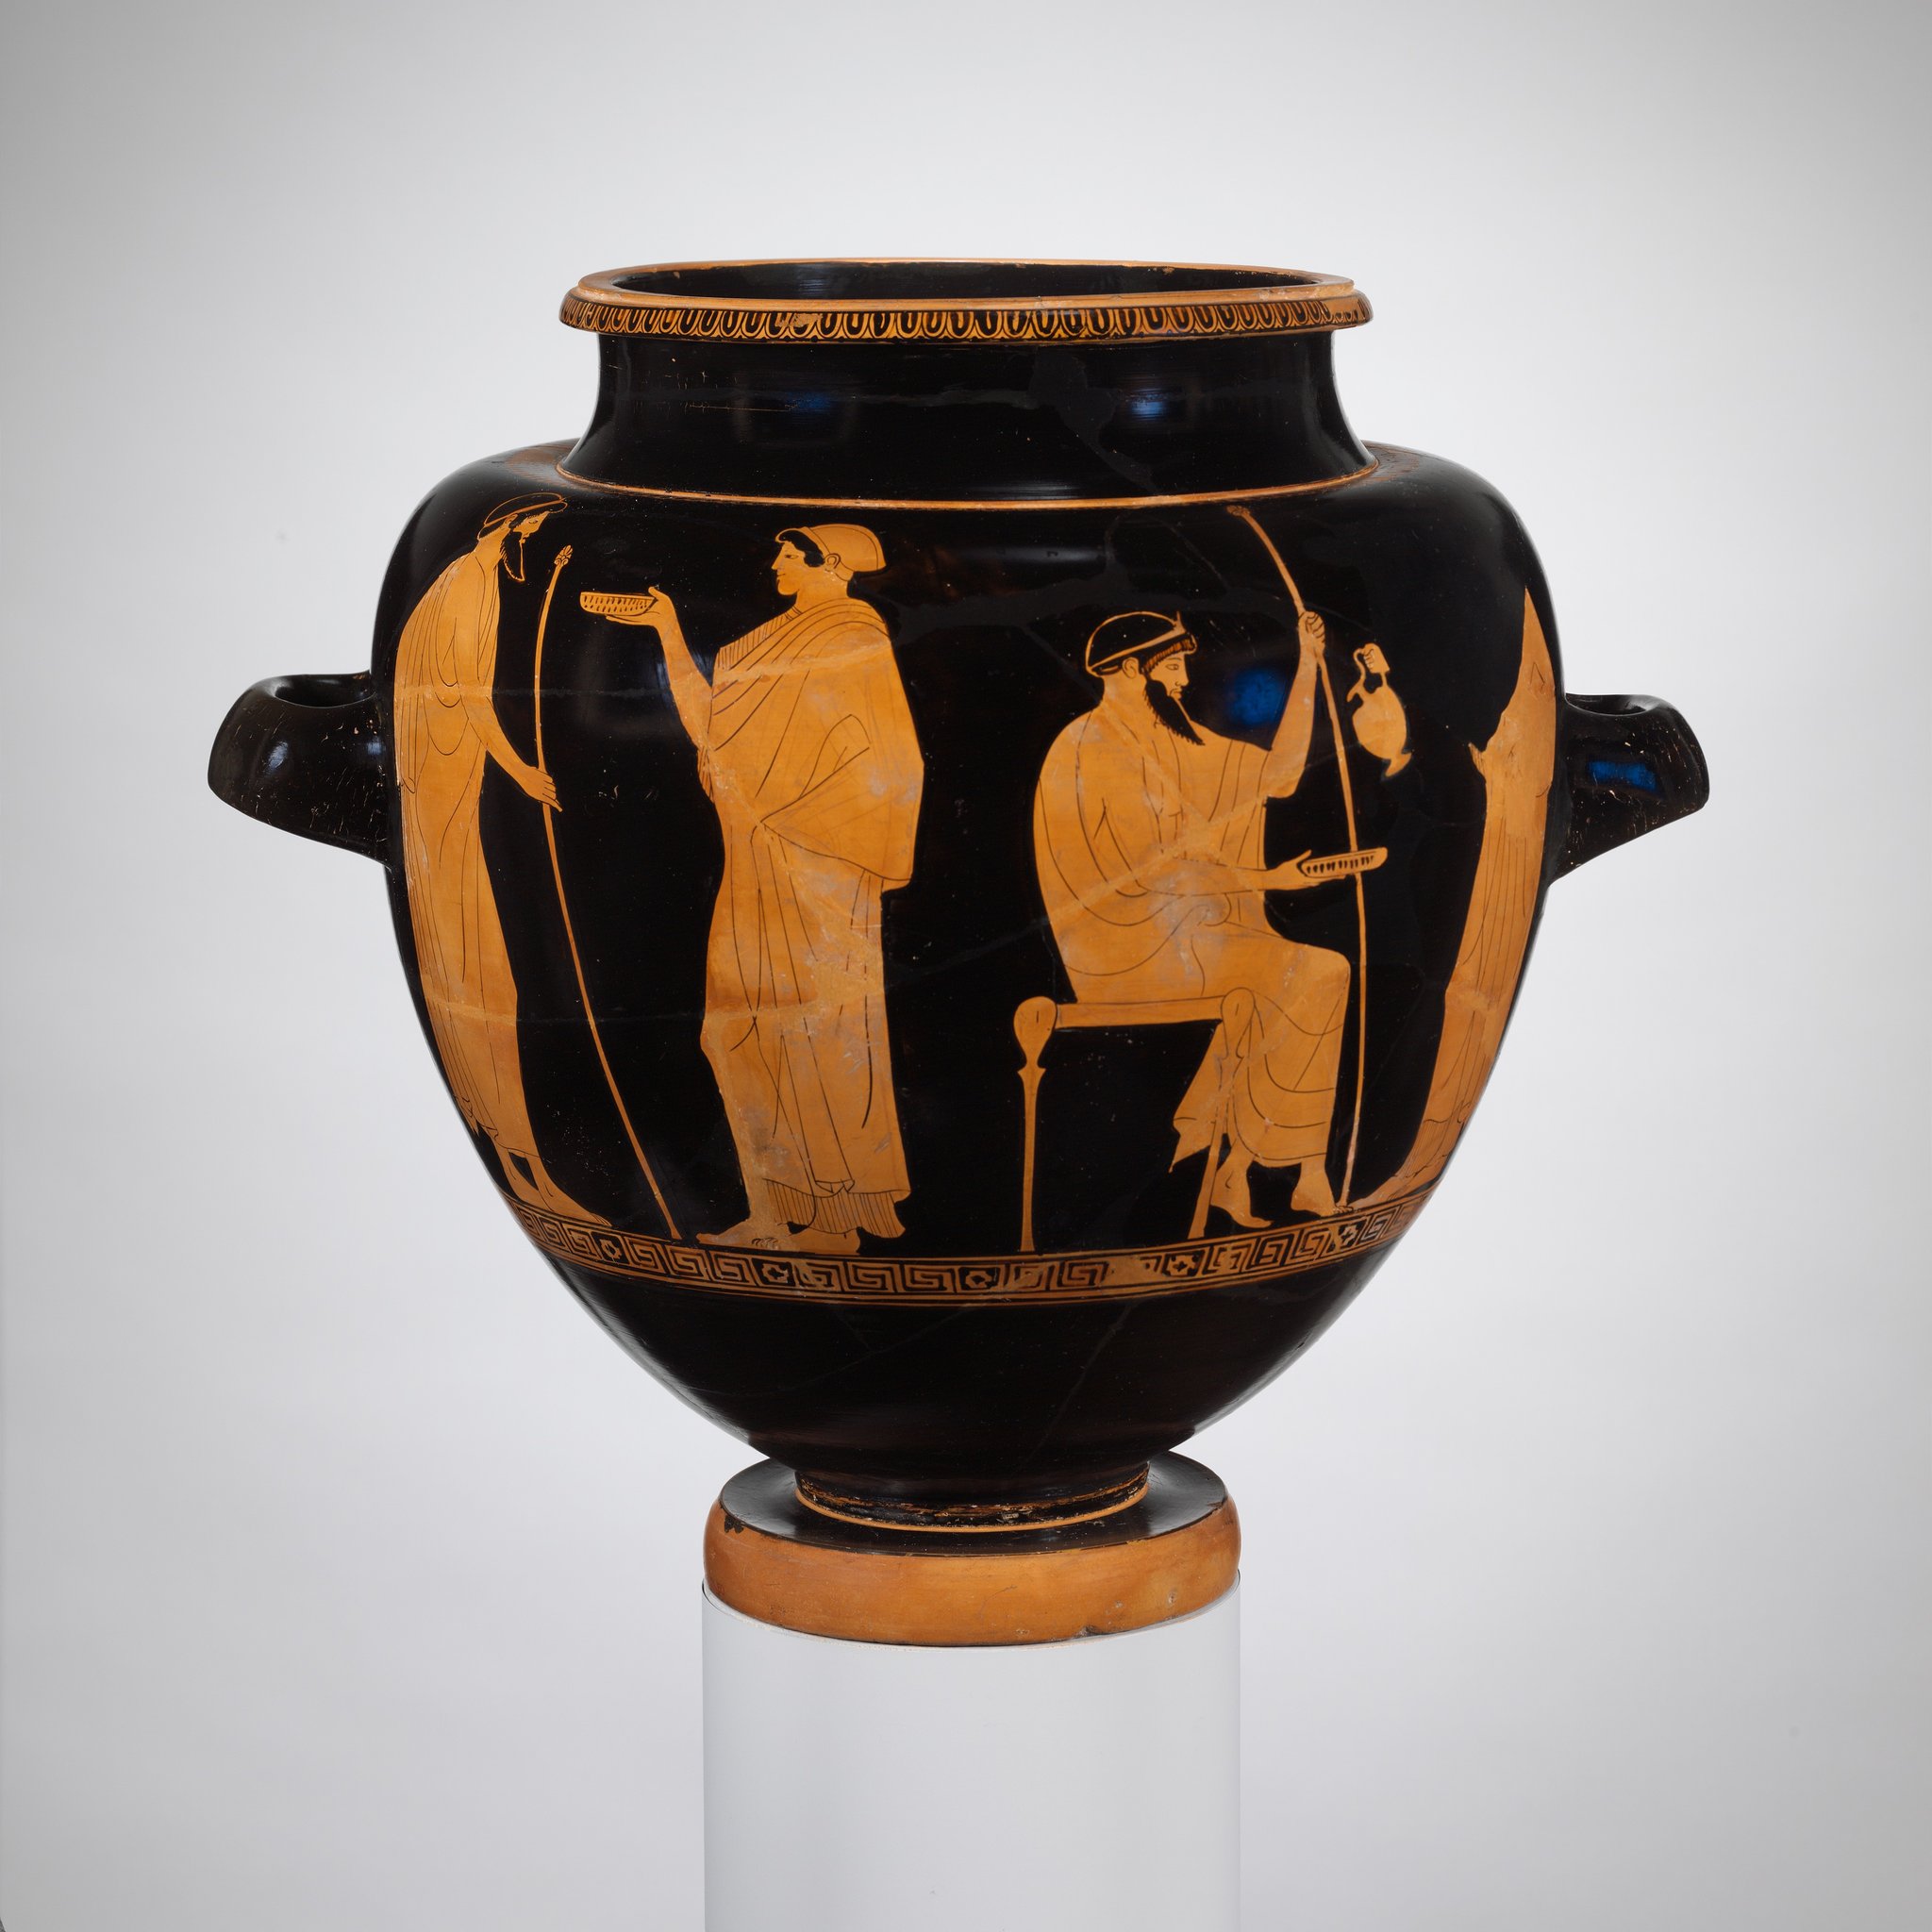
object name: stamnos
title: Terracotta stamnos (jar)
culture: greek, attic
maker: copenhagen painter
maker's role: artist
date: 480 BCE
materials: terracotta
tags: men,women